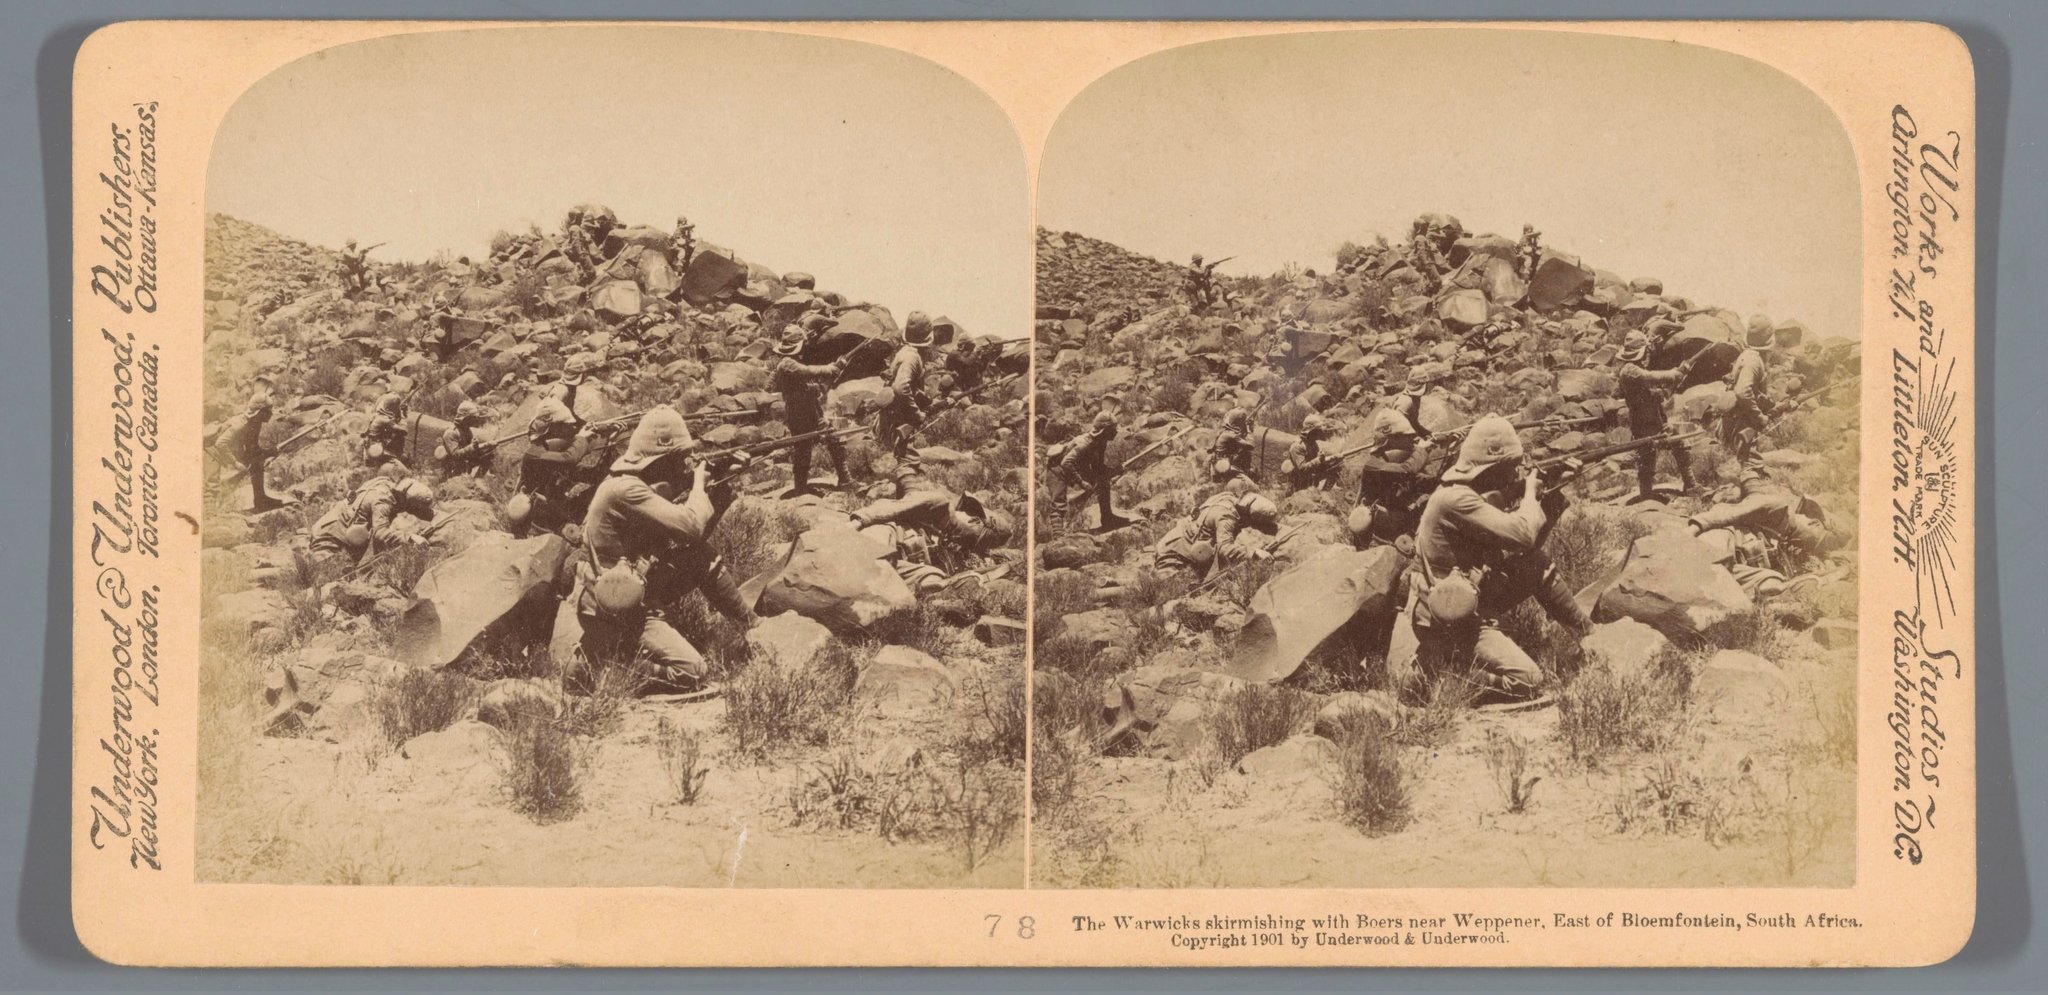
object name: stereograph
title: The Warwicks skirmishing with Boers near Weppener, East of Bloemfontein, S.A.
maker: Anonymous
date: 1901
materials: cardboard, paper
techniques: albumen print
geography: new york city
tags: rock-formations, siege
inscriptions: copyright notice: ‘Copyright 1901 by Underwood and Underwood.’, number: ‘78’, inscription: ‘Works and Studios ~/ Arlington, N.J. Littleton, N.H. Washington, D.C.’, inscription